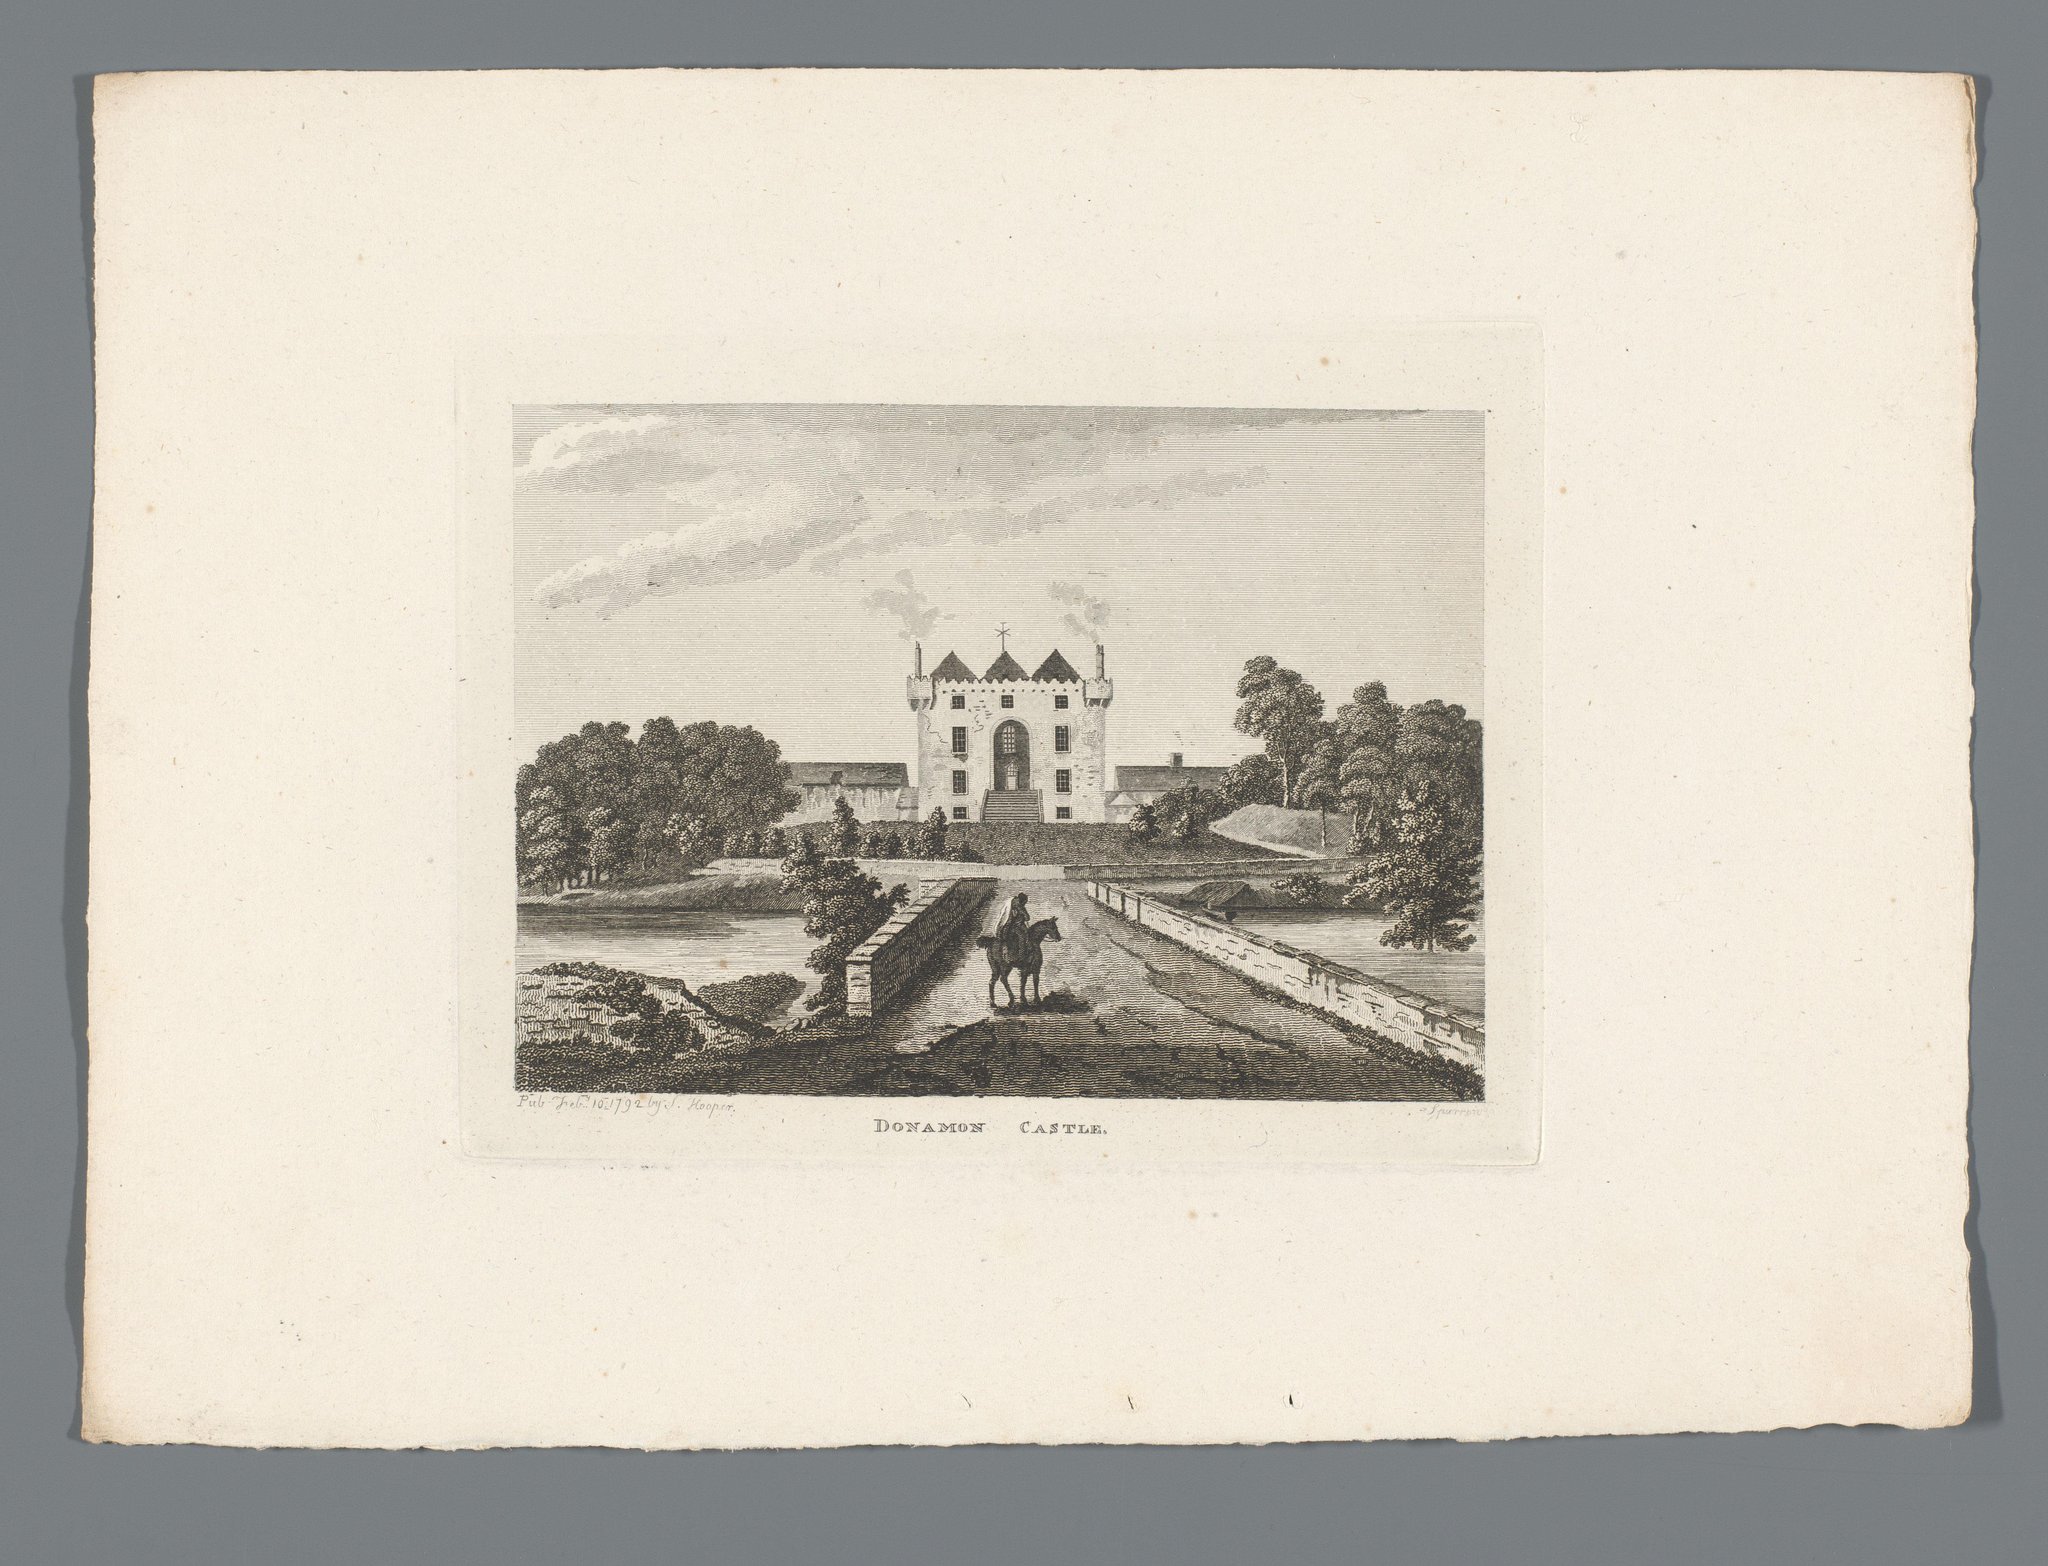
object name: book illustration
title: Donamon Castle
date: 1792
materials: paper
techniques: etching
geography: london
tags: landscape with ruins, landscape with tower or castle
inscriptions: date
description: Prent verschenen in: Grose, Francis. The antiquities of Ireland, dl. 2. Londen: S. Hooper, 1795.